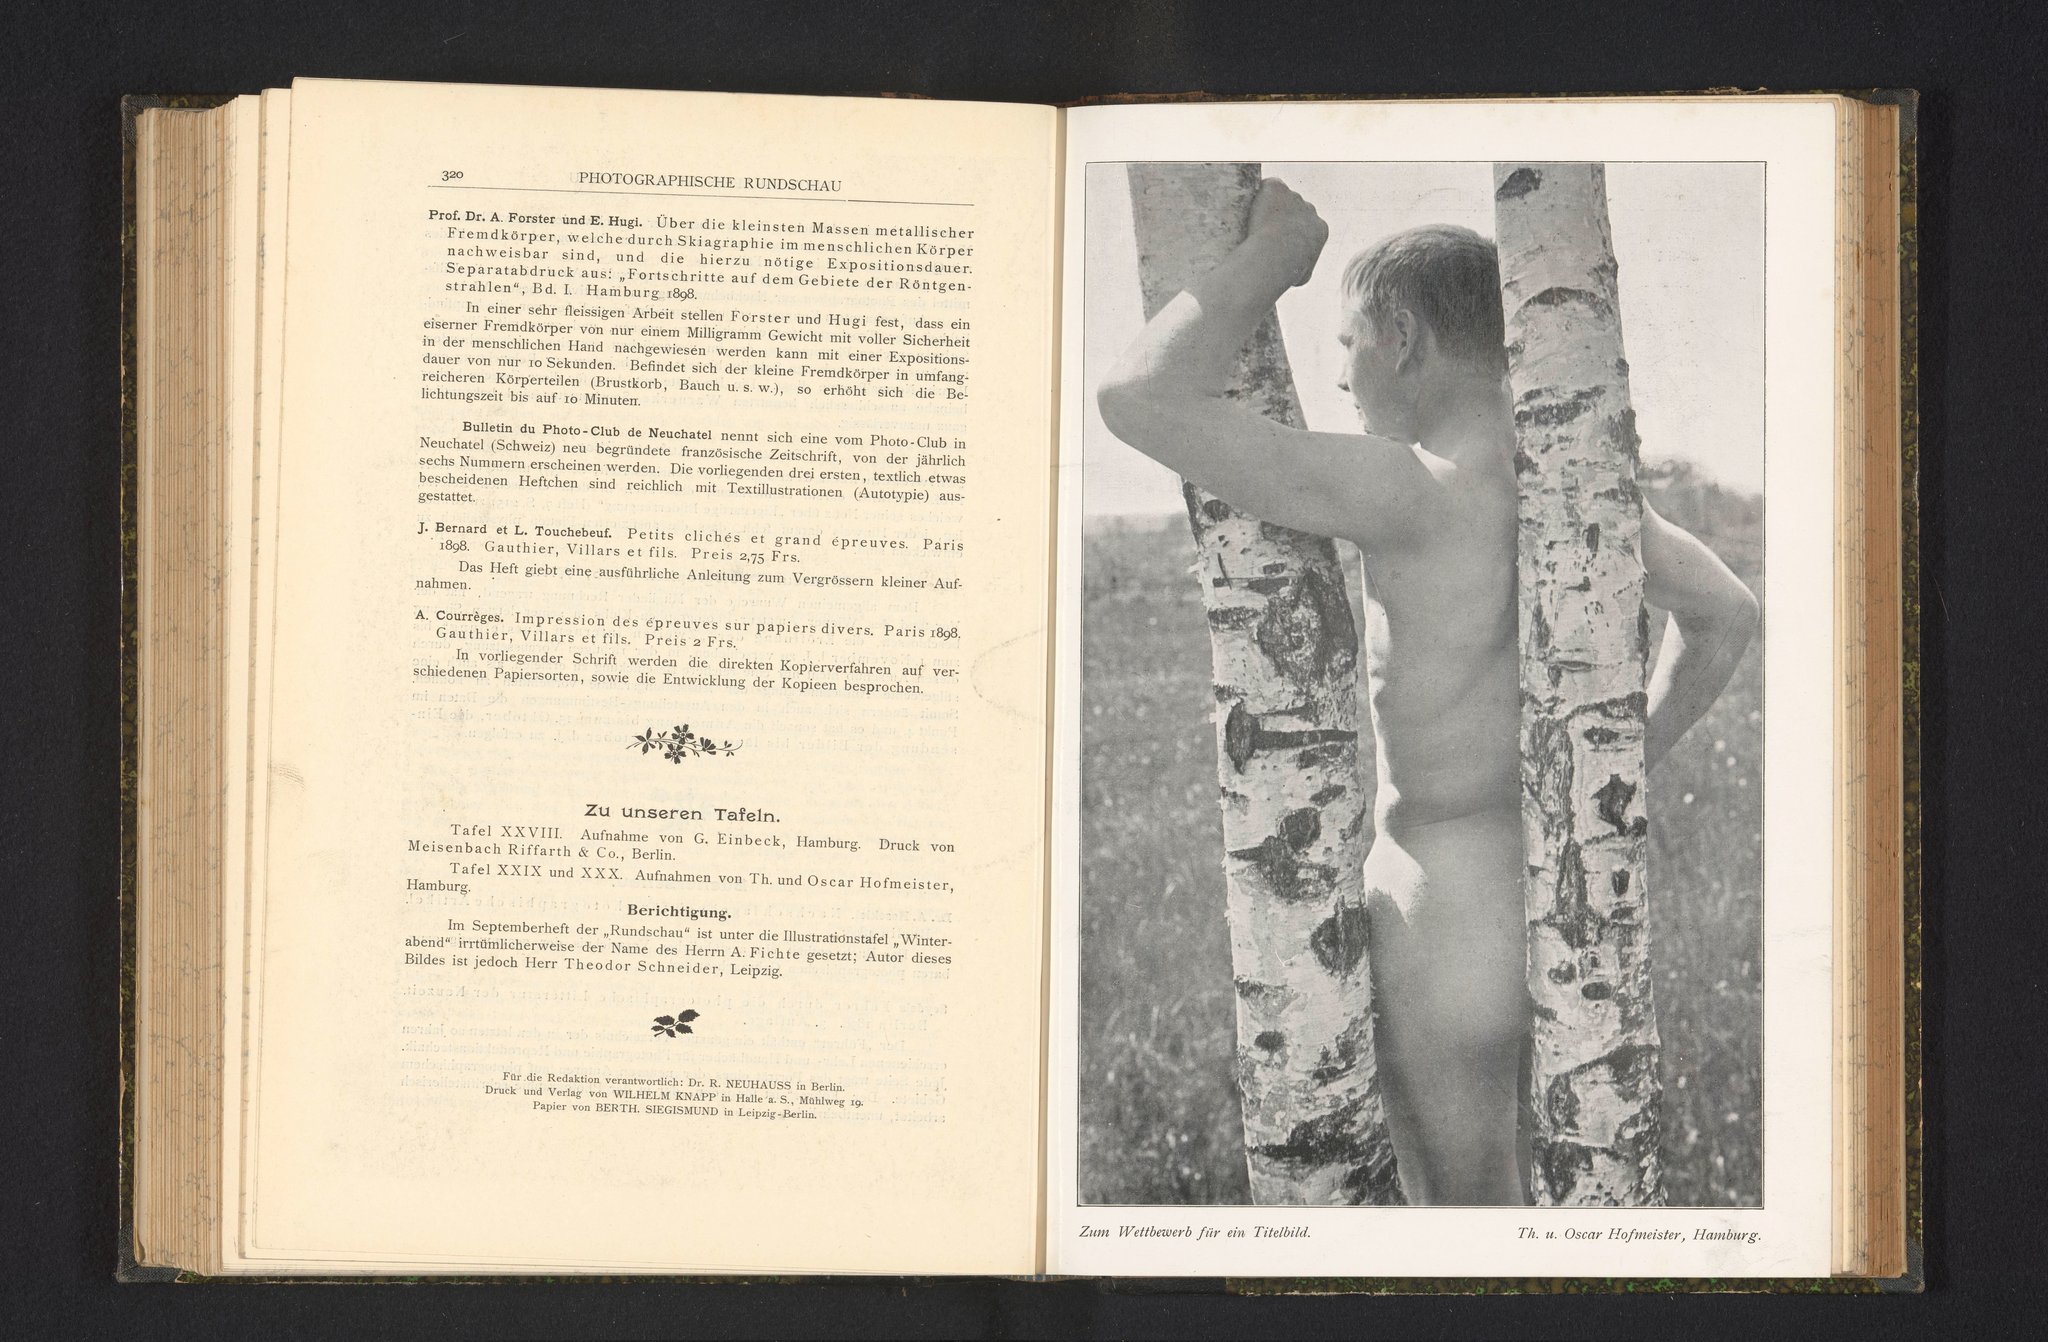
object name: page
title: Zum wettbewerb für ein titelbild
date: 1893-1898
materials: paper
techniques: autotype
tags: trees, the (nude) human figure; 'corpo humano' (ripa), youth, adolescent